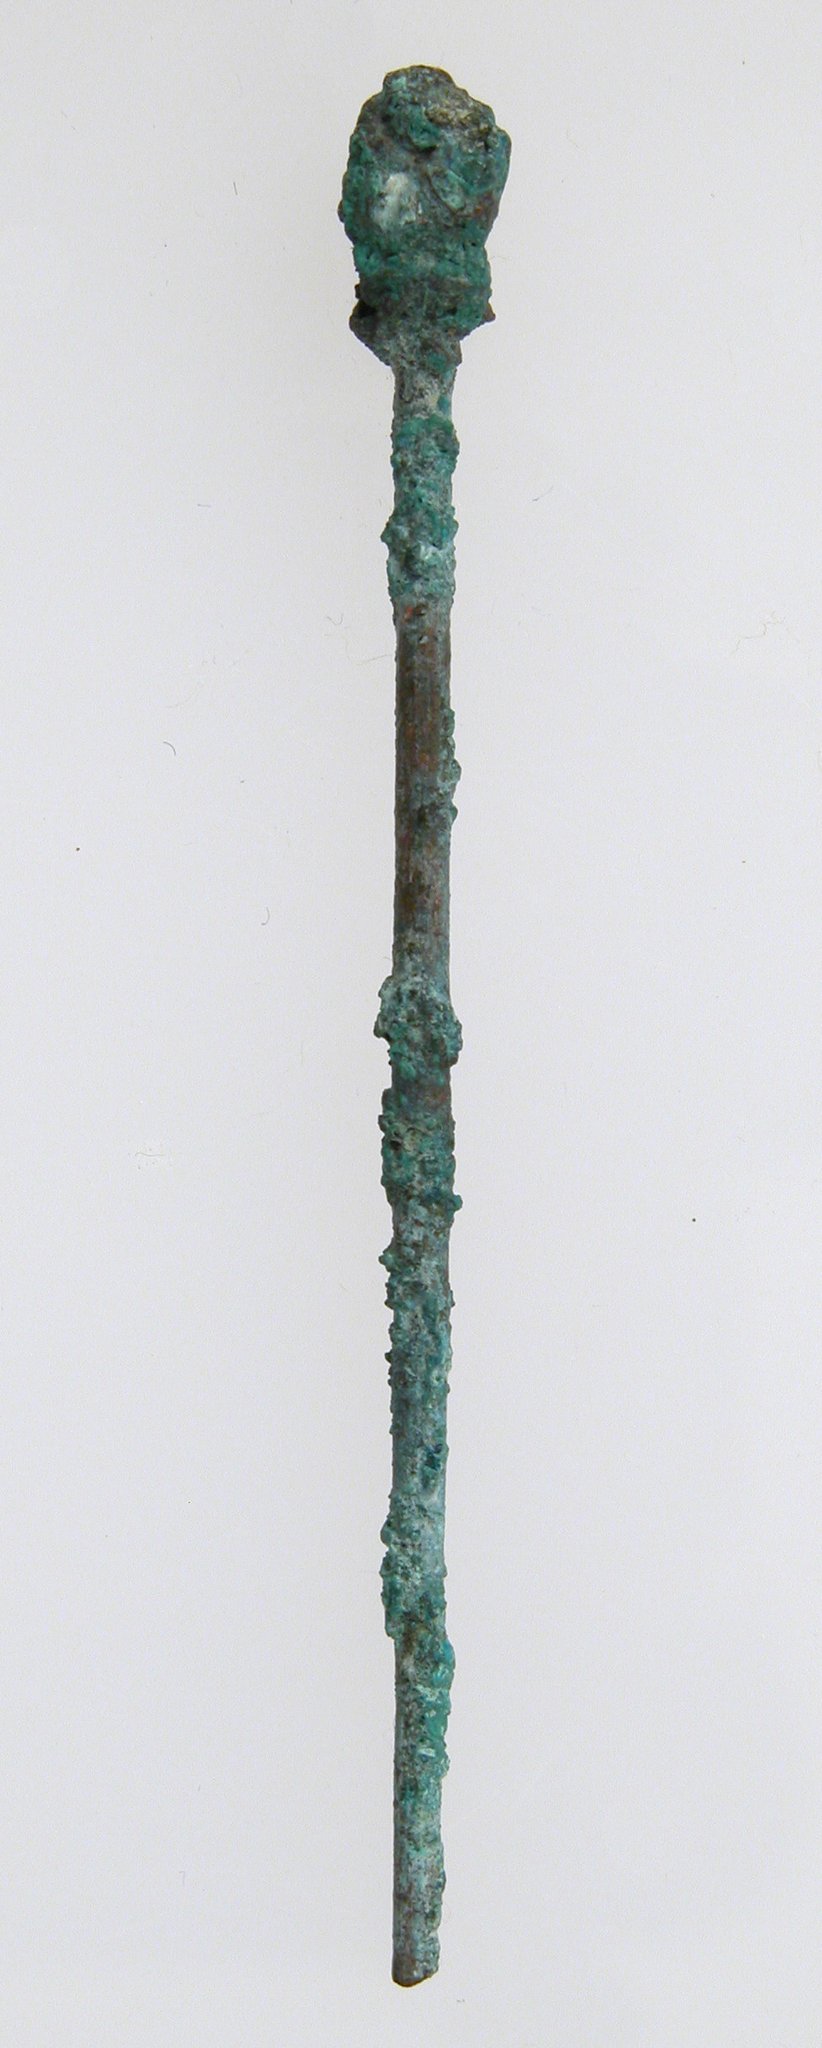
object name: hairpin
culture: roman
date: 200-500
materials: copper alloy